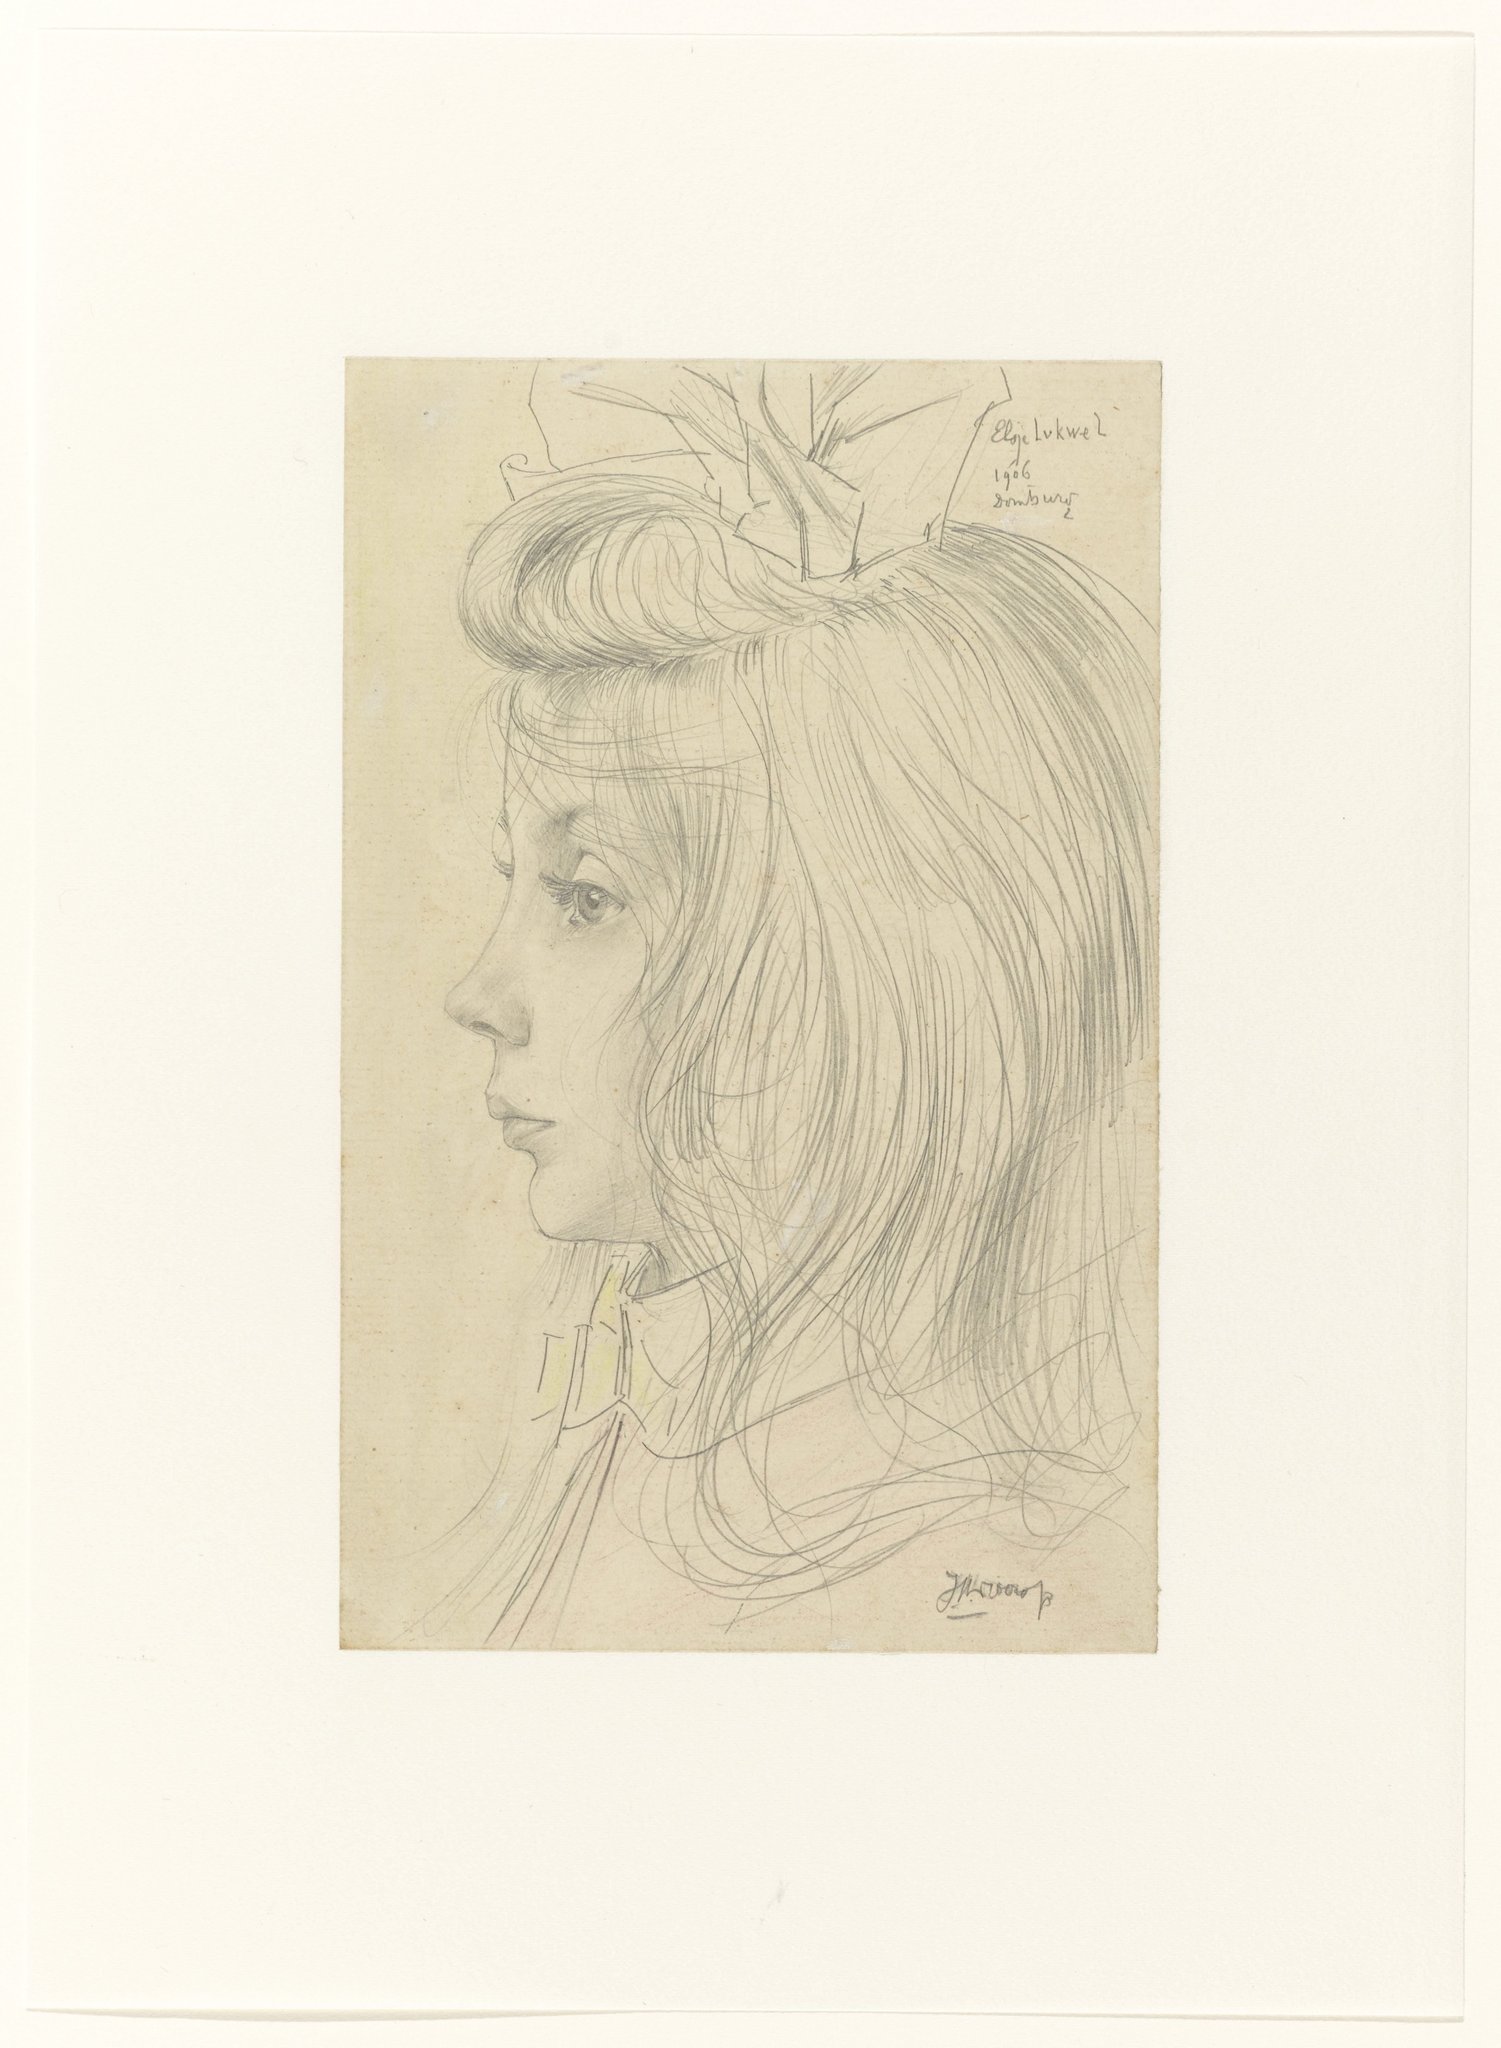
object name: drawing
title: Portret van Elsje Lukwel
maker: jan toorop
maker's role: draughtsman, painter, print maker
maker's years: 1858-1928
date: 1906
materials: chalk, paper, pencil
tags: historical persons